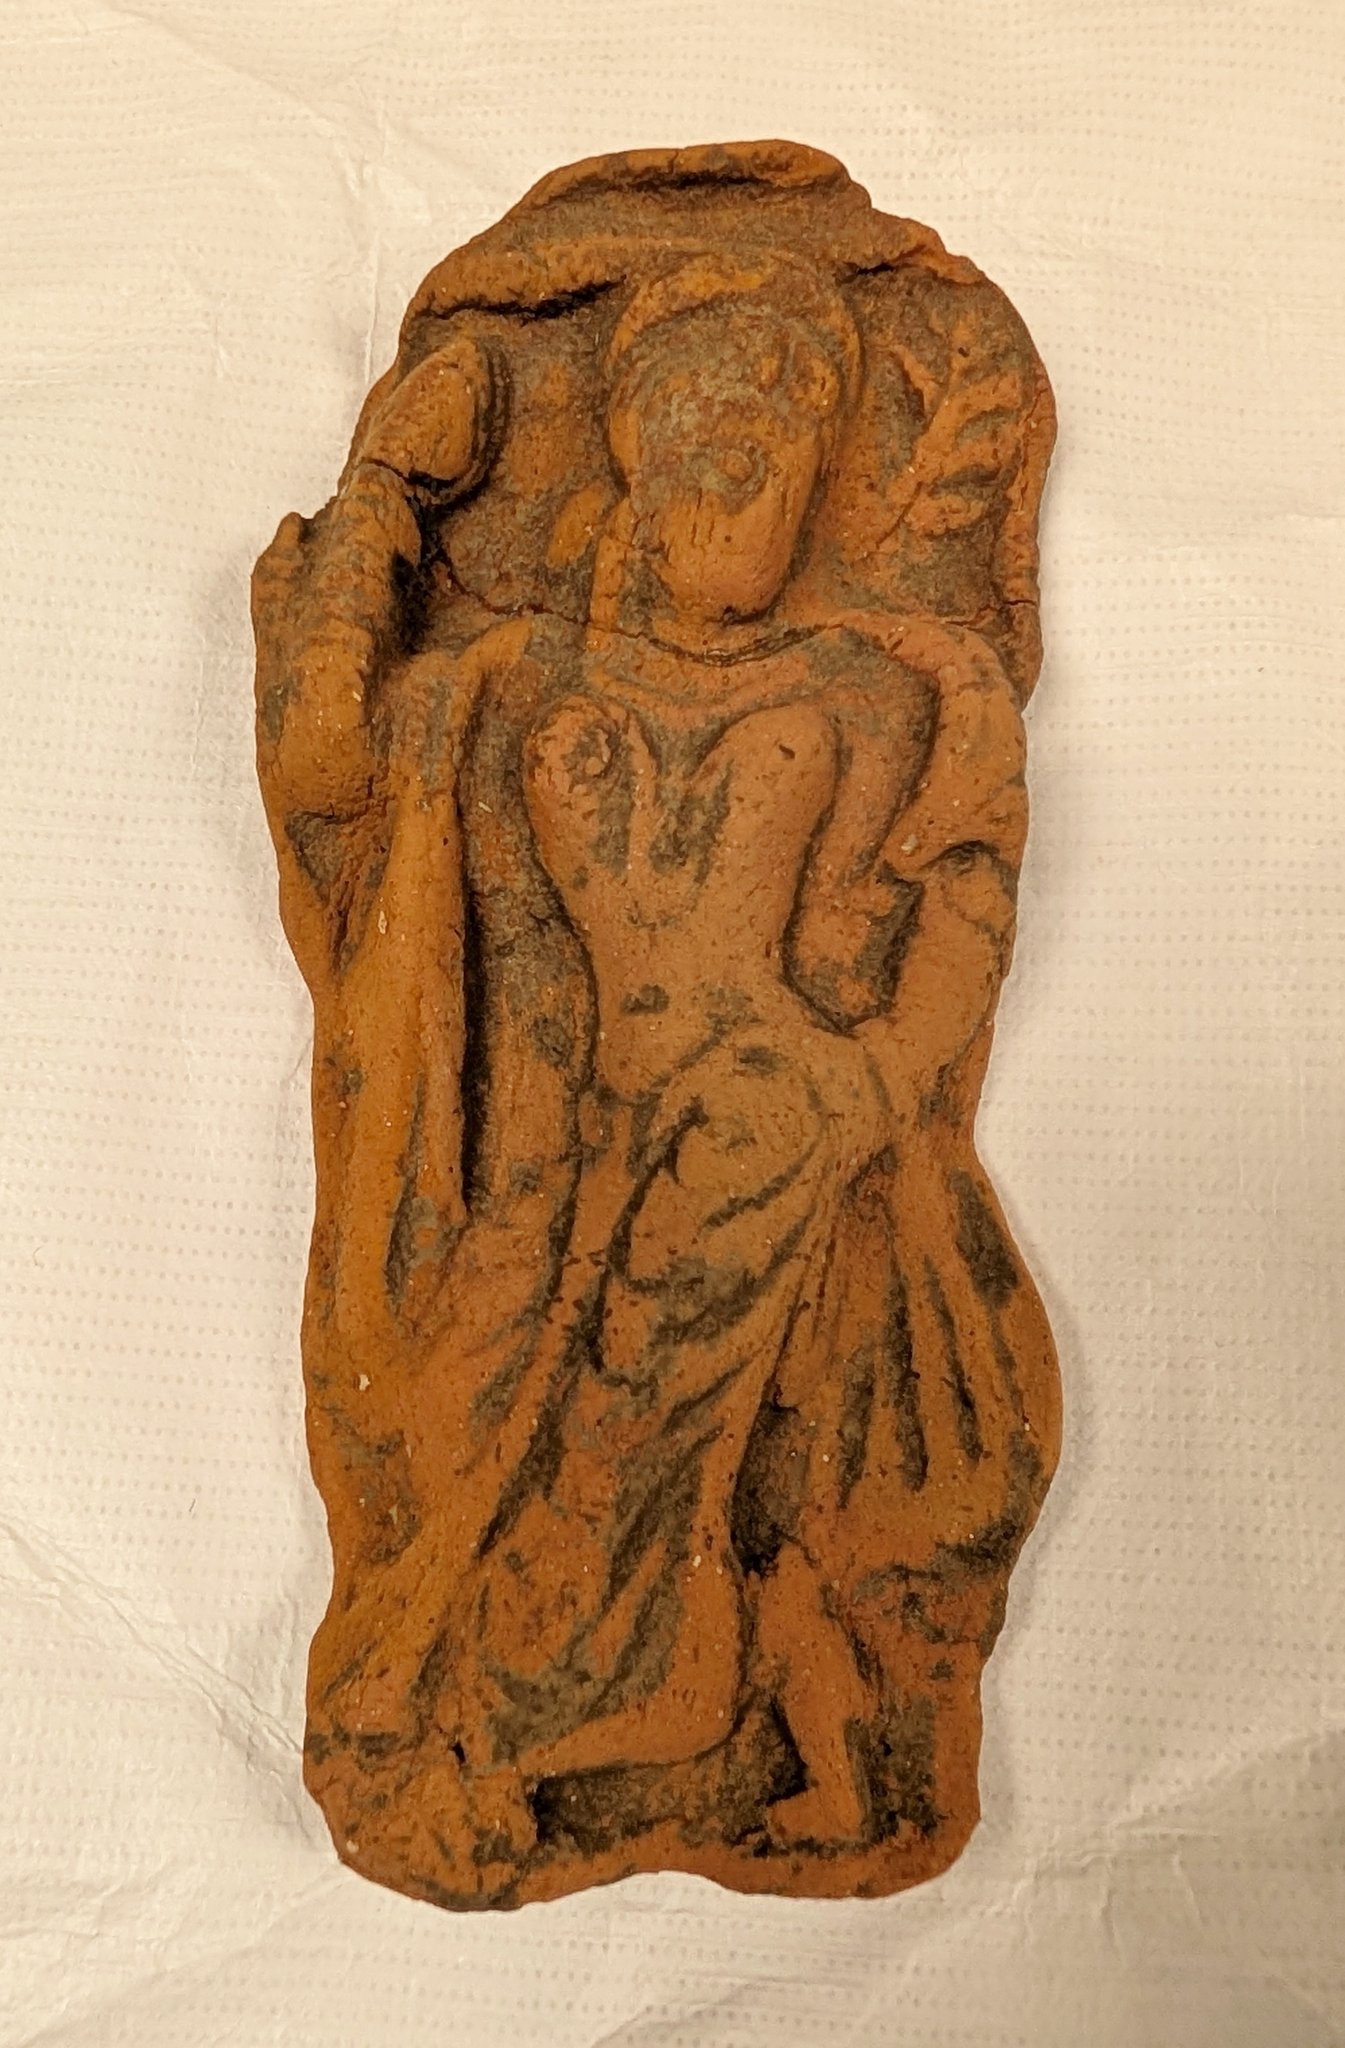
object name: plaque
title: Plaque in the Form of a Female Figure (Study Collection)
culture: pakistani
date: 101-300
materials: terracotta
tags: gandhara